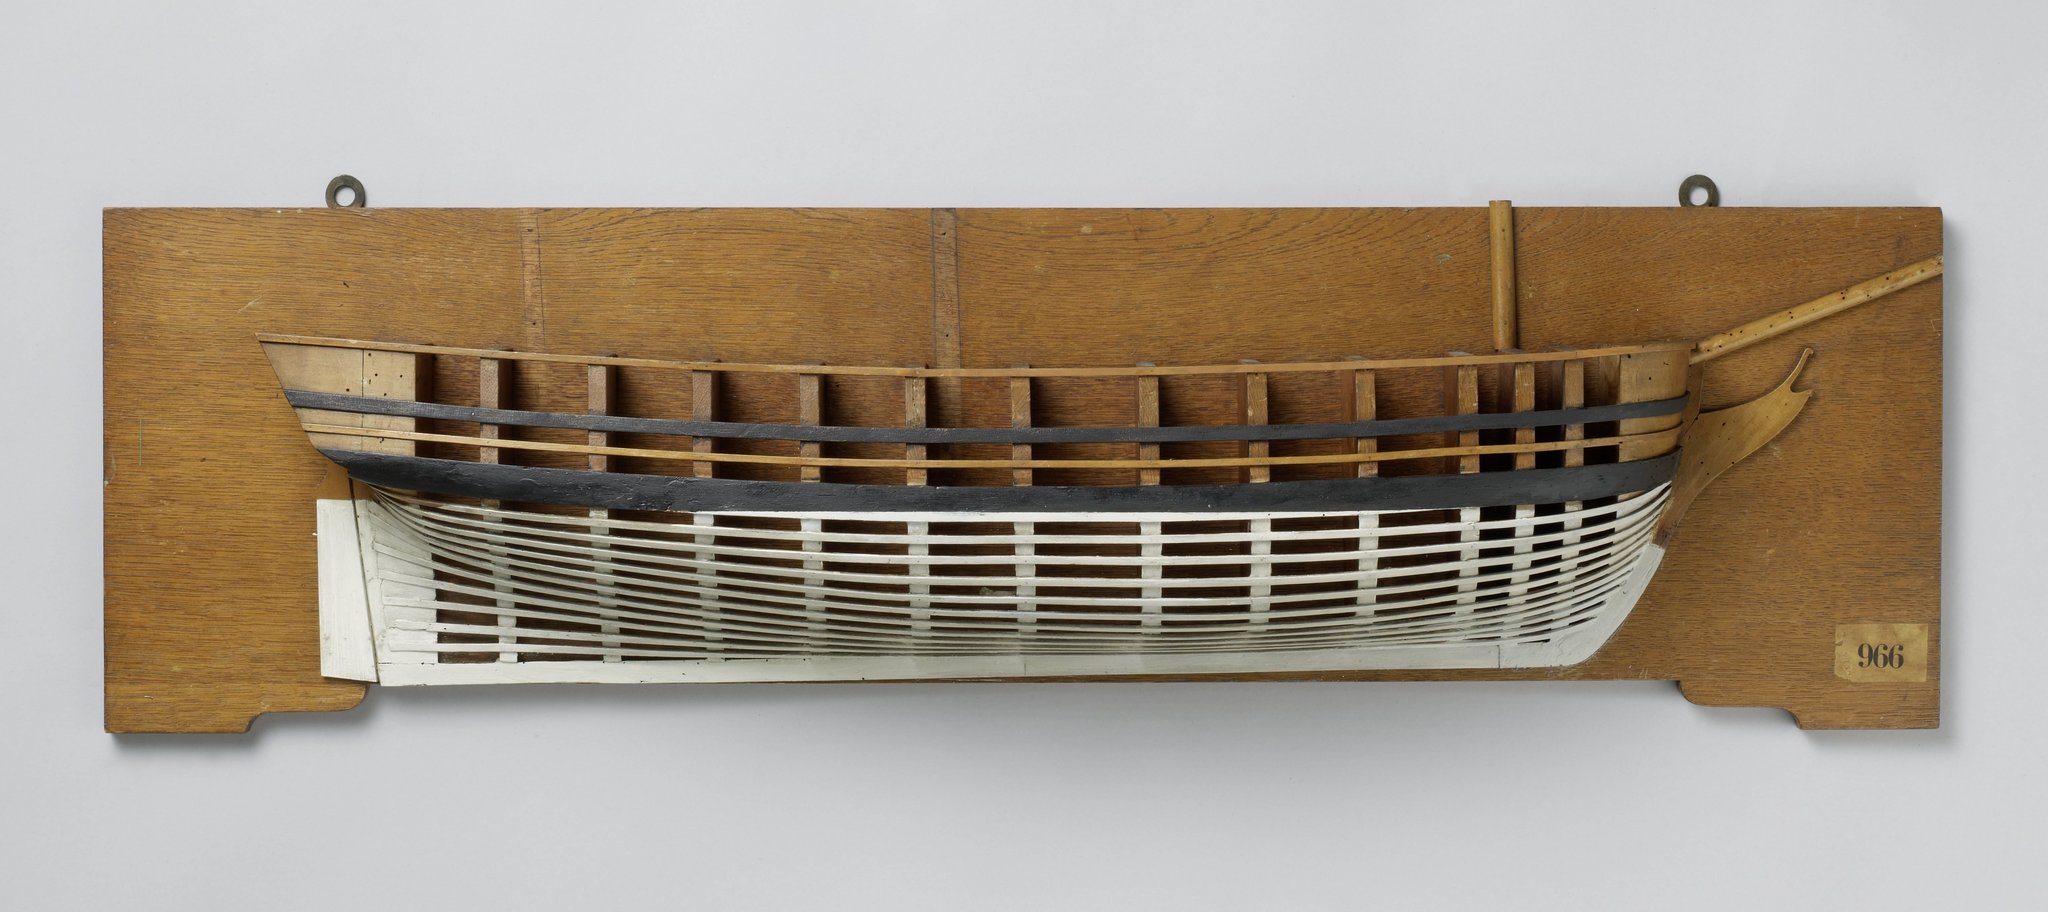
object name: builder's model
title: Half Model of a Sloop of War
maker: Anonymous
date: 1780-1820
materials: wood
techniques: polychromy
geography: netherlands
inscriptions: label, bottom right: ‘966’ former inventory label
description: Gepolychromeerd mallenmodel (stuurboord) van een driemaster. Geen geschutpoorten en geen dekken aangegeven. Gewrongen spiegel, hol wulf, geen details van hek of zijgalerij; recht roer met vierkante roerkoning. Zeeg naar voren en naar achter oplopend, één barkhout en één reehout. Scherp gepiekt rondspant.